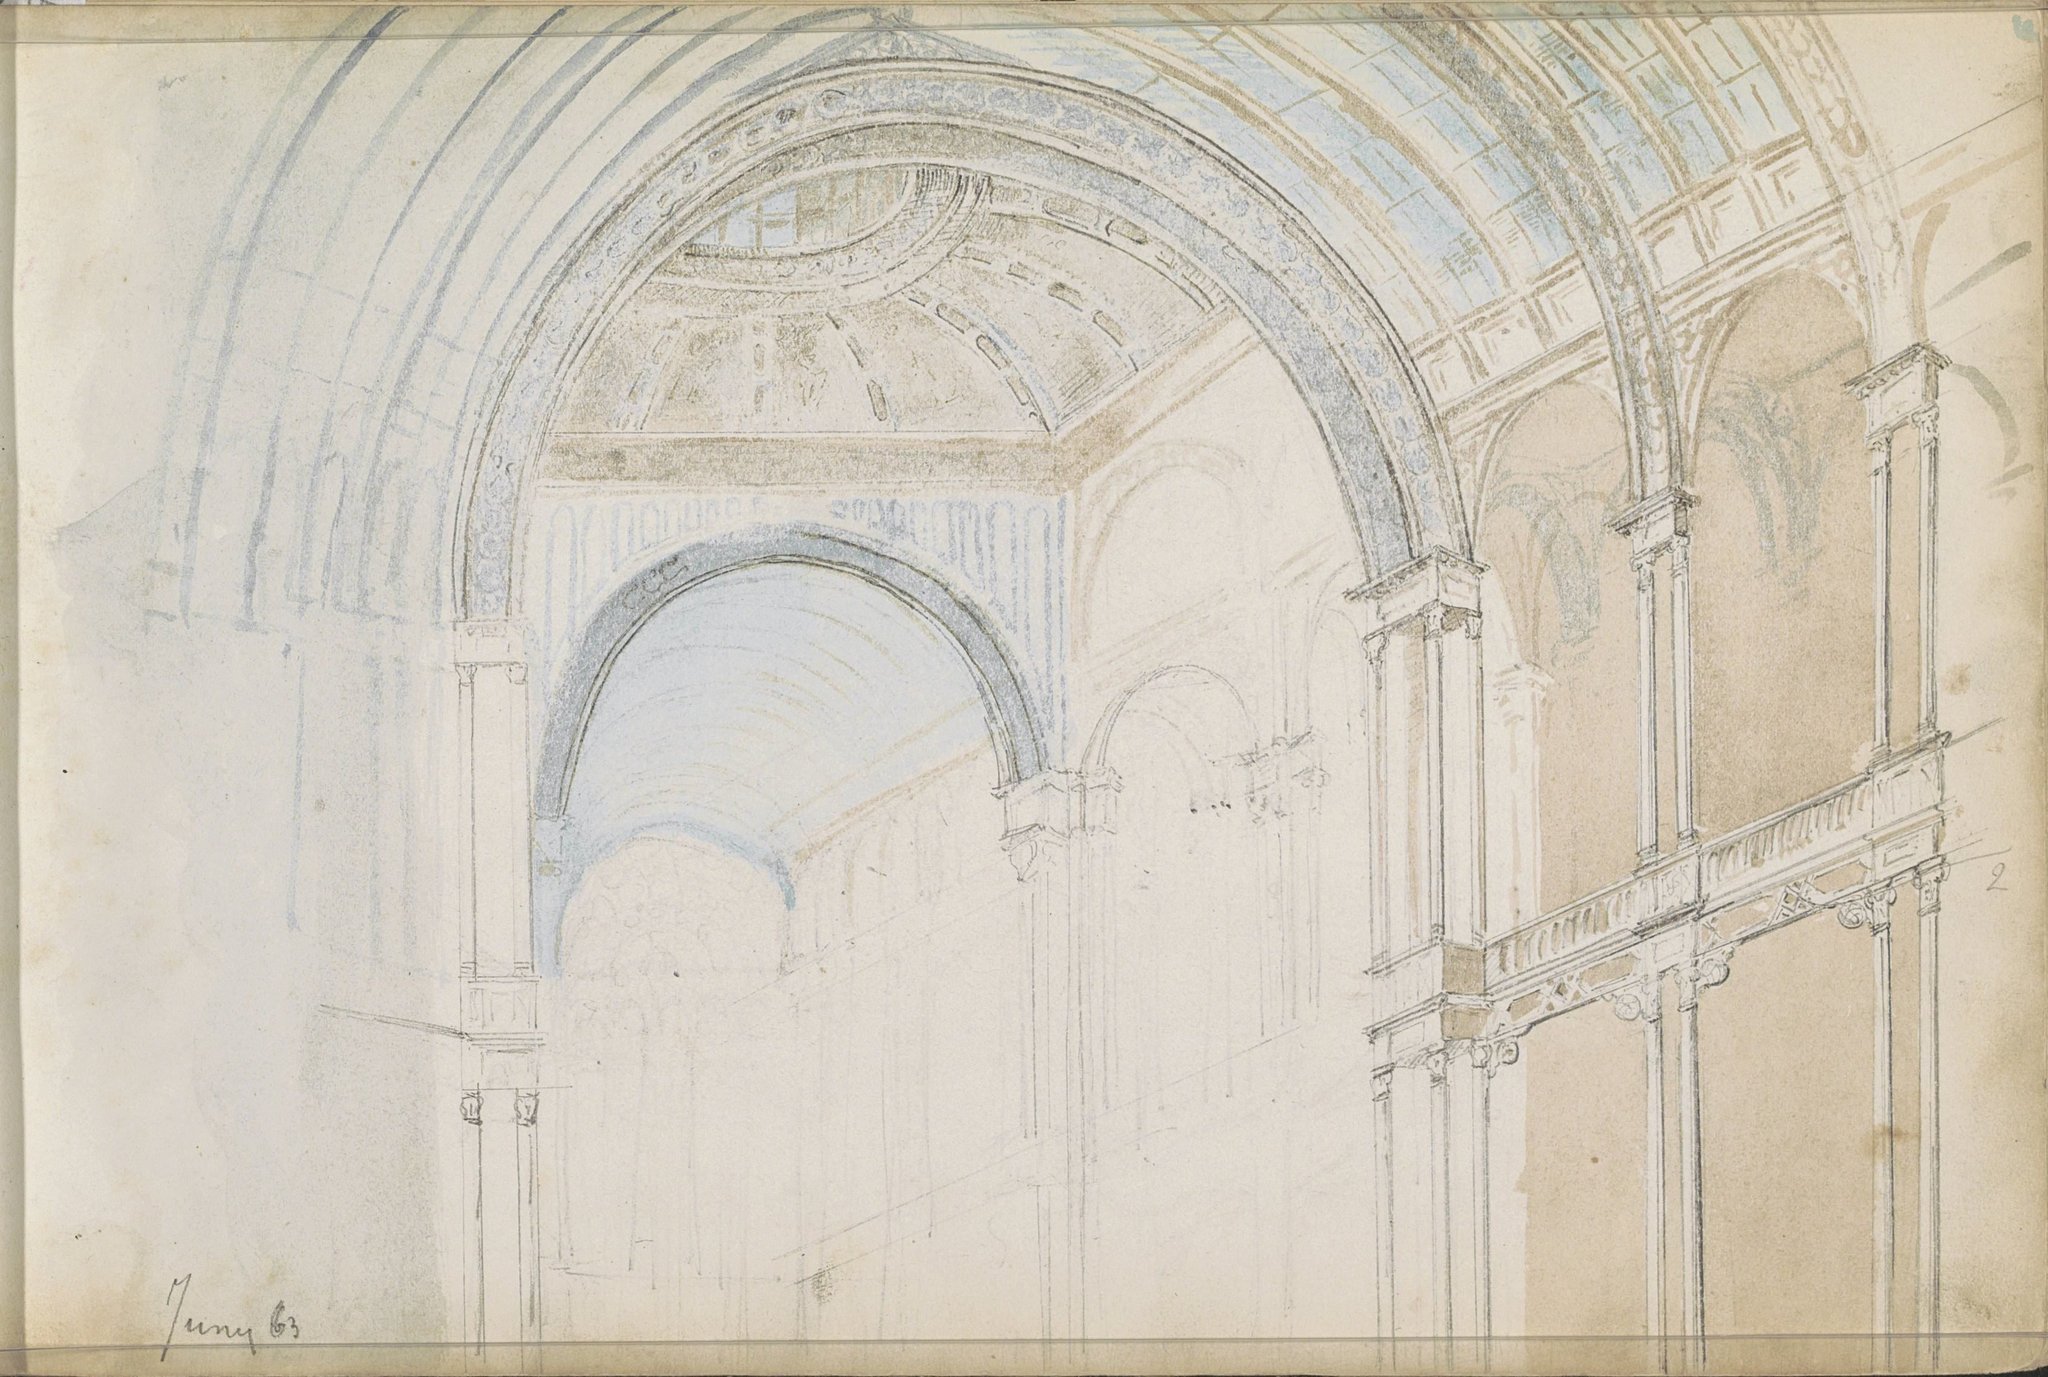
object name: sketchbook leaf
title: Interieur van het Paleis voor Volksvlijt te Amsterdam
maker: isaac gosschalk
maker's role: draughtsman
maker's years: 1838-1907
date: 1806-1863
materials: paper, pencil, watercolor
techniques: brush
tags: edifice, e.g.: public building, department store - aa - civic architecture: inside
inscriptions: date: ‘Juny 63’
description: Blad 13 recto uit een schetsboek met 58 bladen.